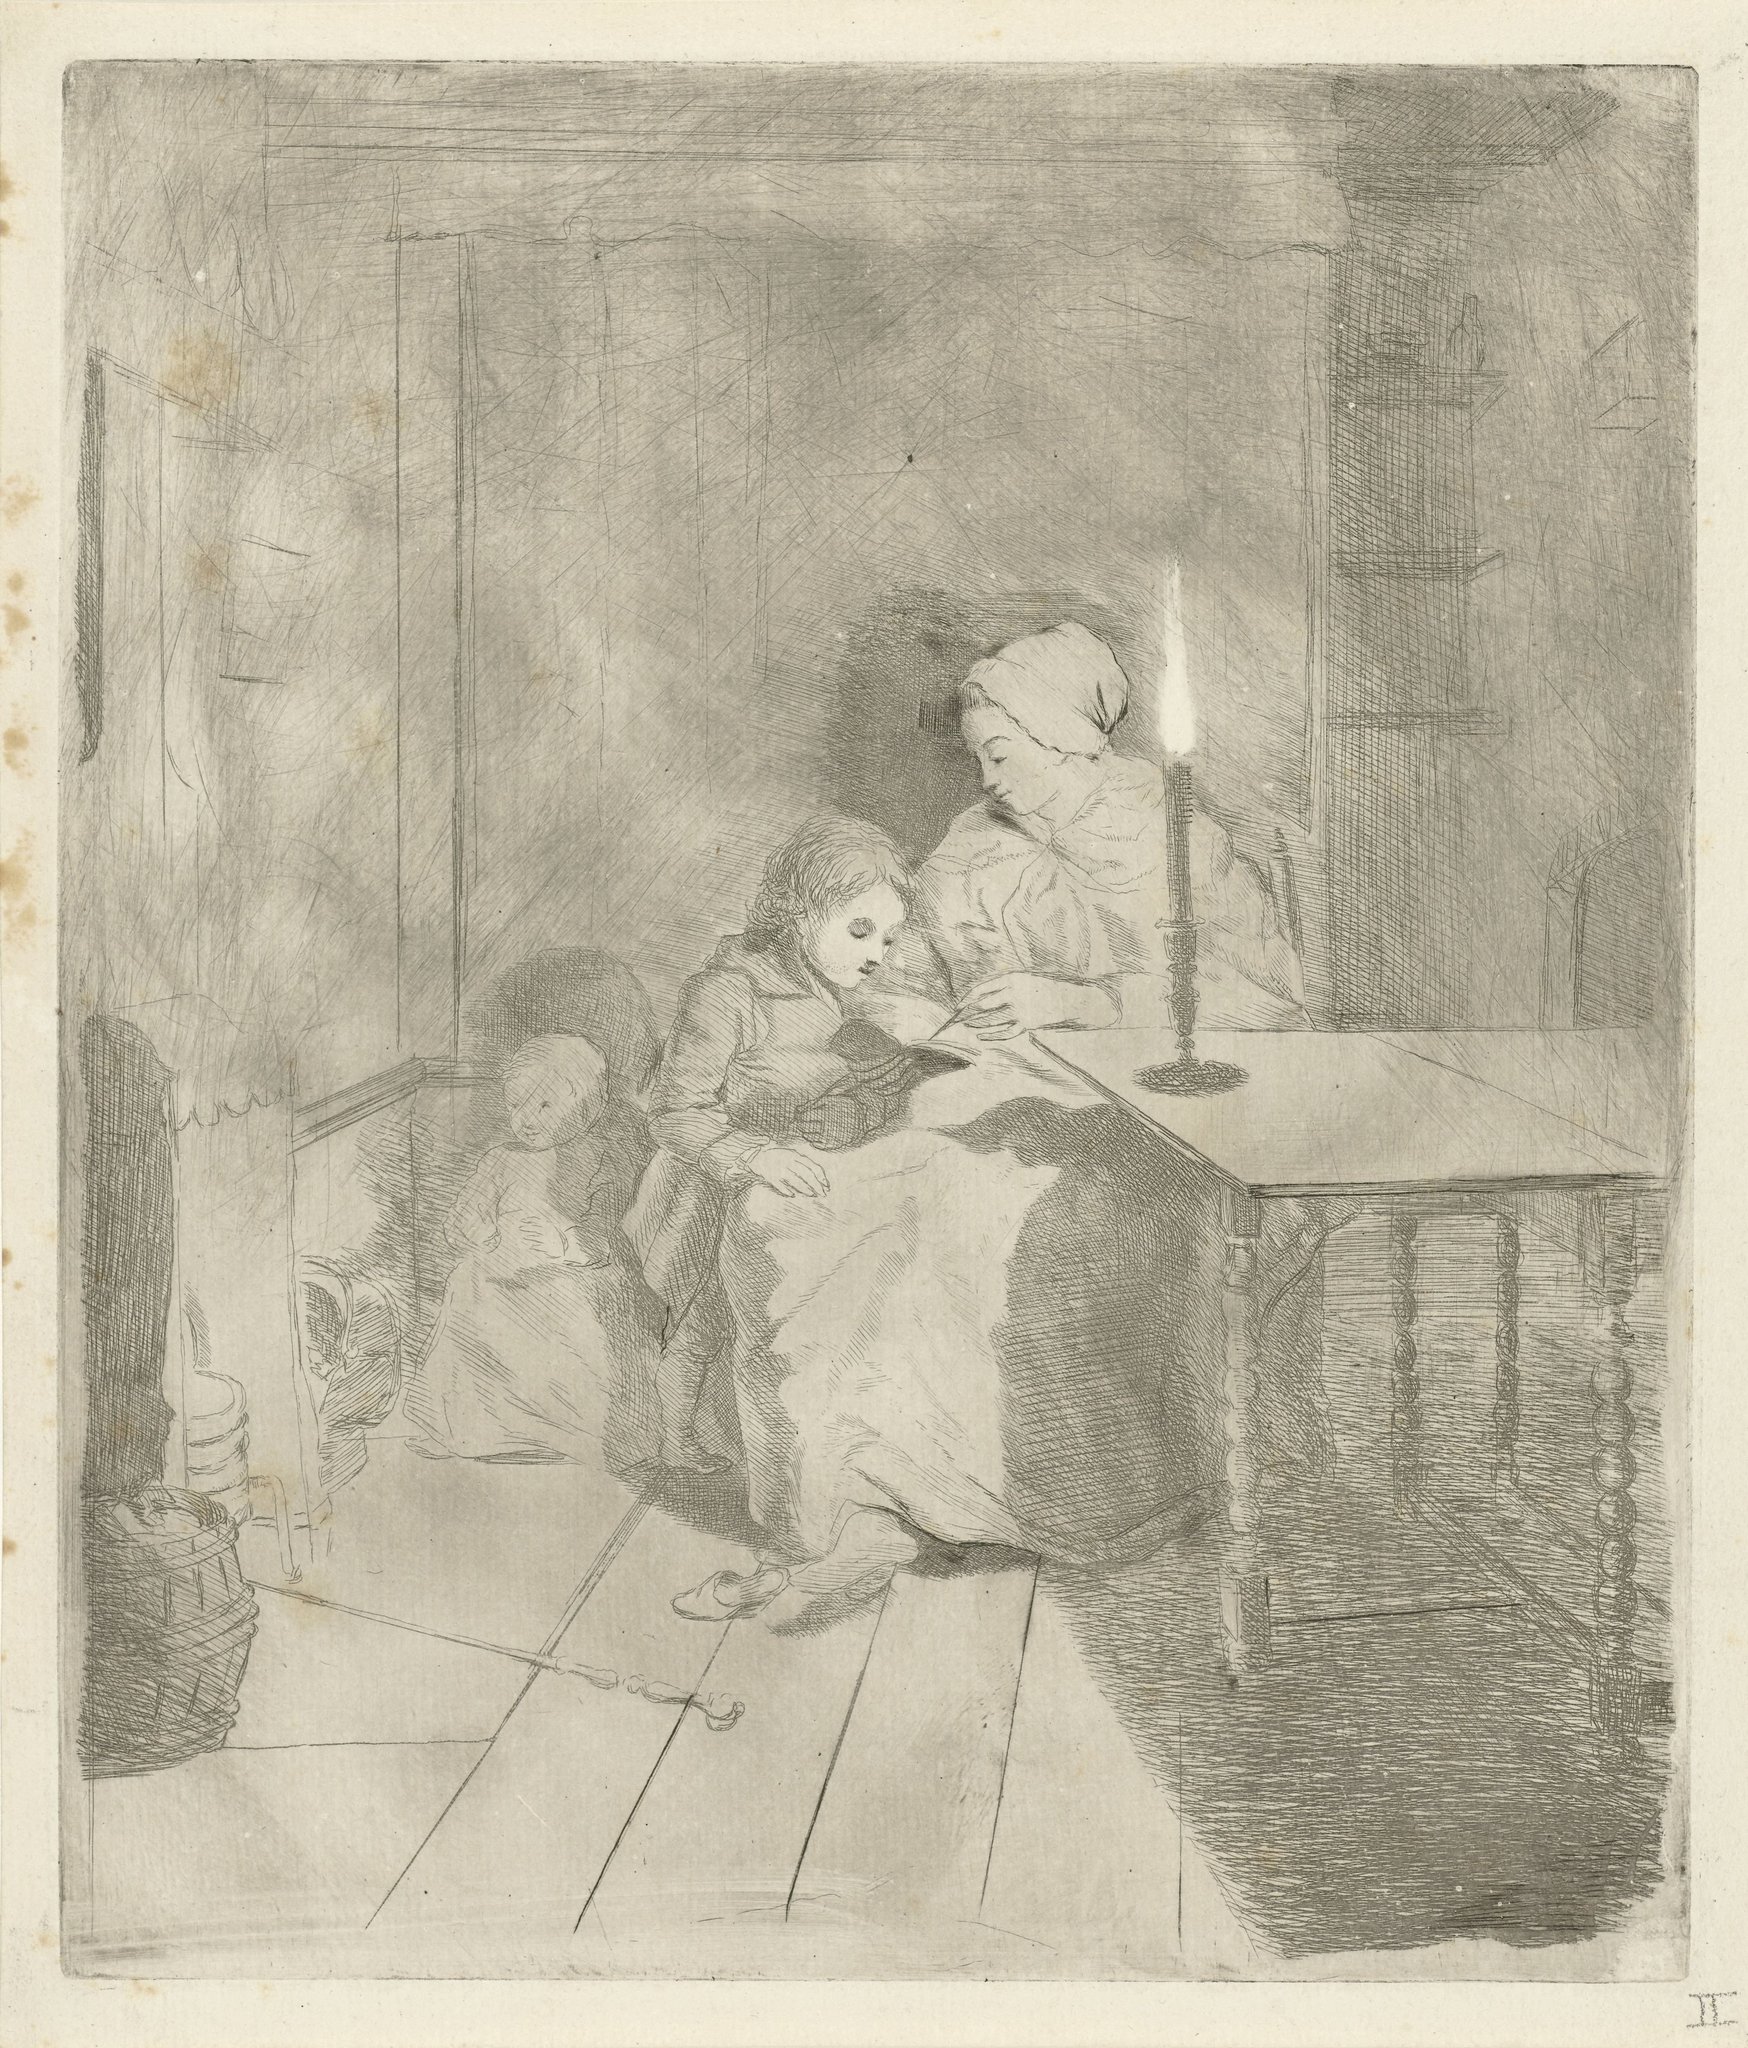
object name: print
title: L'instruction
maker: louis bernard coclers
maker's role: draughtsman, print maker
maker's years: 1741-1817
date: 1756-1817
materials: paper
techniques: etching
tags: mother and child(ren), woman and child(ren) (family group), teacher and pupil (+ lesson, lecture), child (at home)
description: In een huiskamer zit een moeder aan tafel. In haar hand houdt ze een boekje waaruit ze haar zoontje les geeft. De jongen staat naast haar en kijkt aandachtig naar het boek. In de hoek zit een tweede kind op een stoeltje. Op tafel een kandelaar met een brandende kaars.